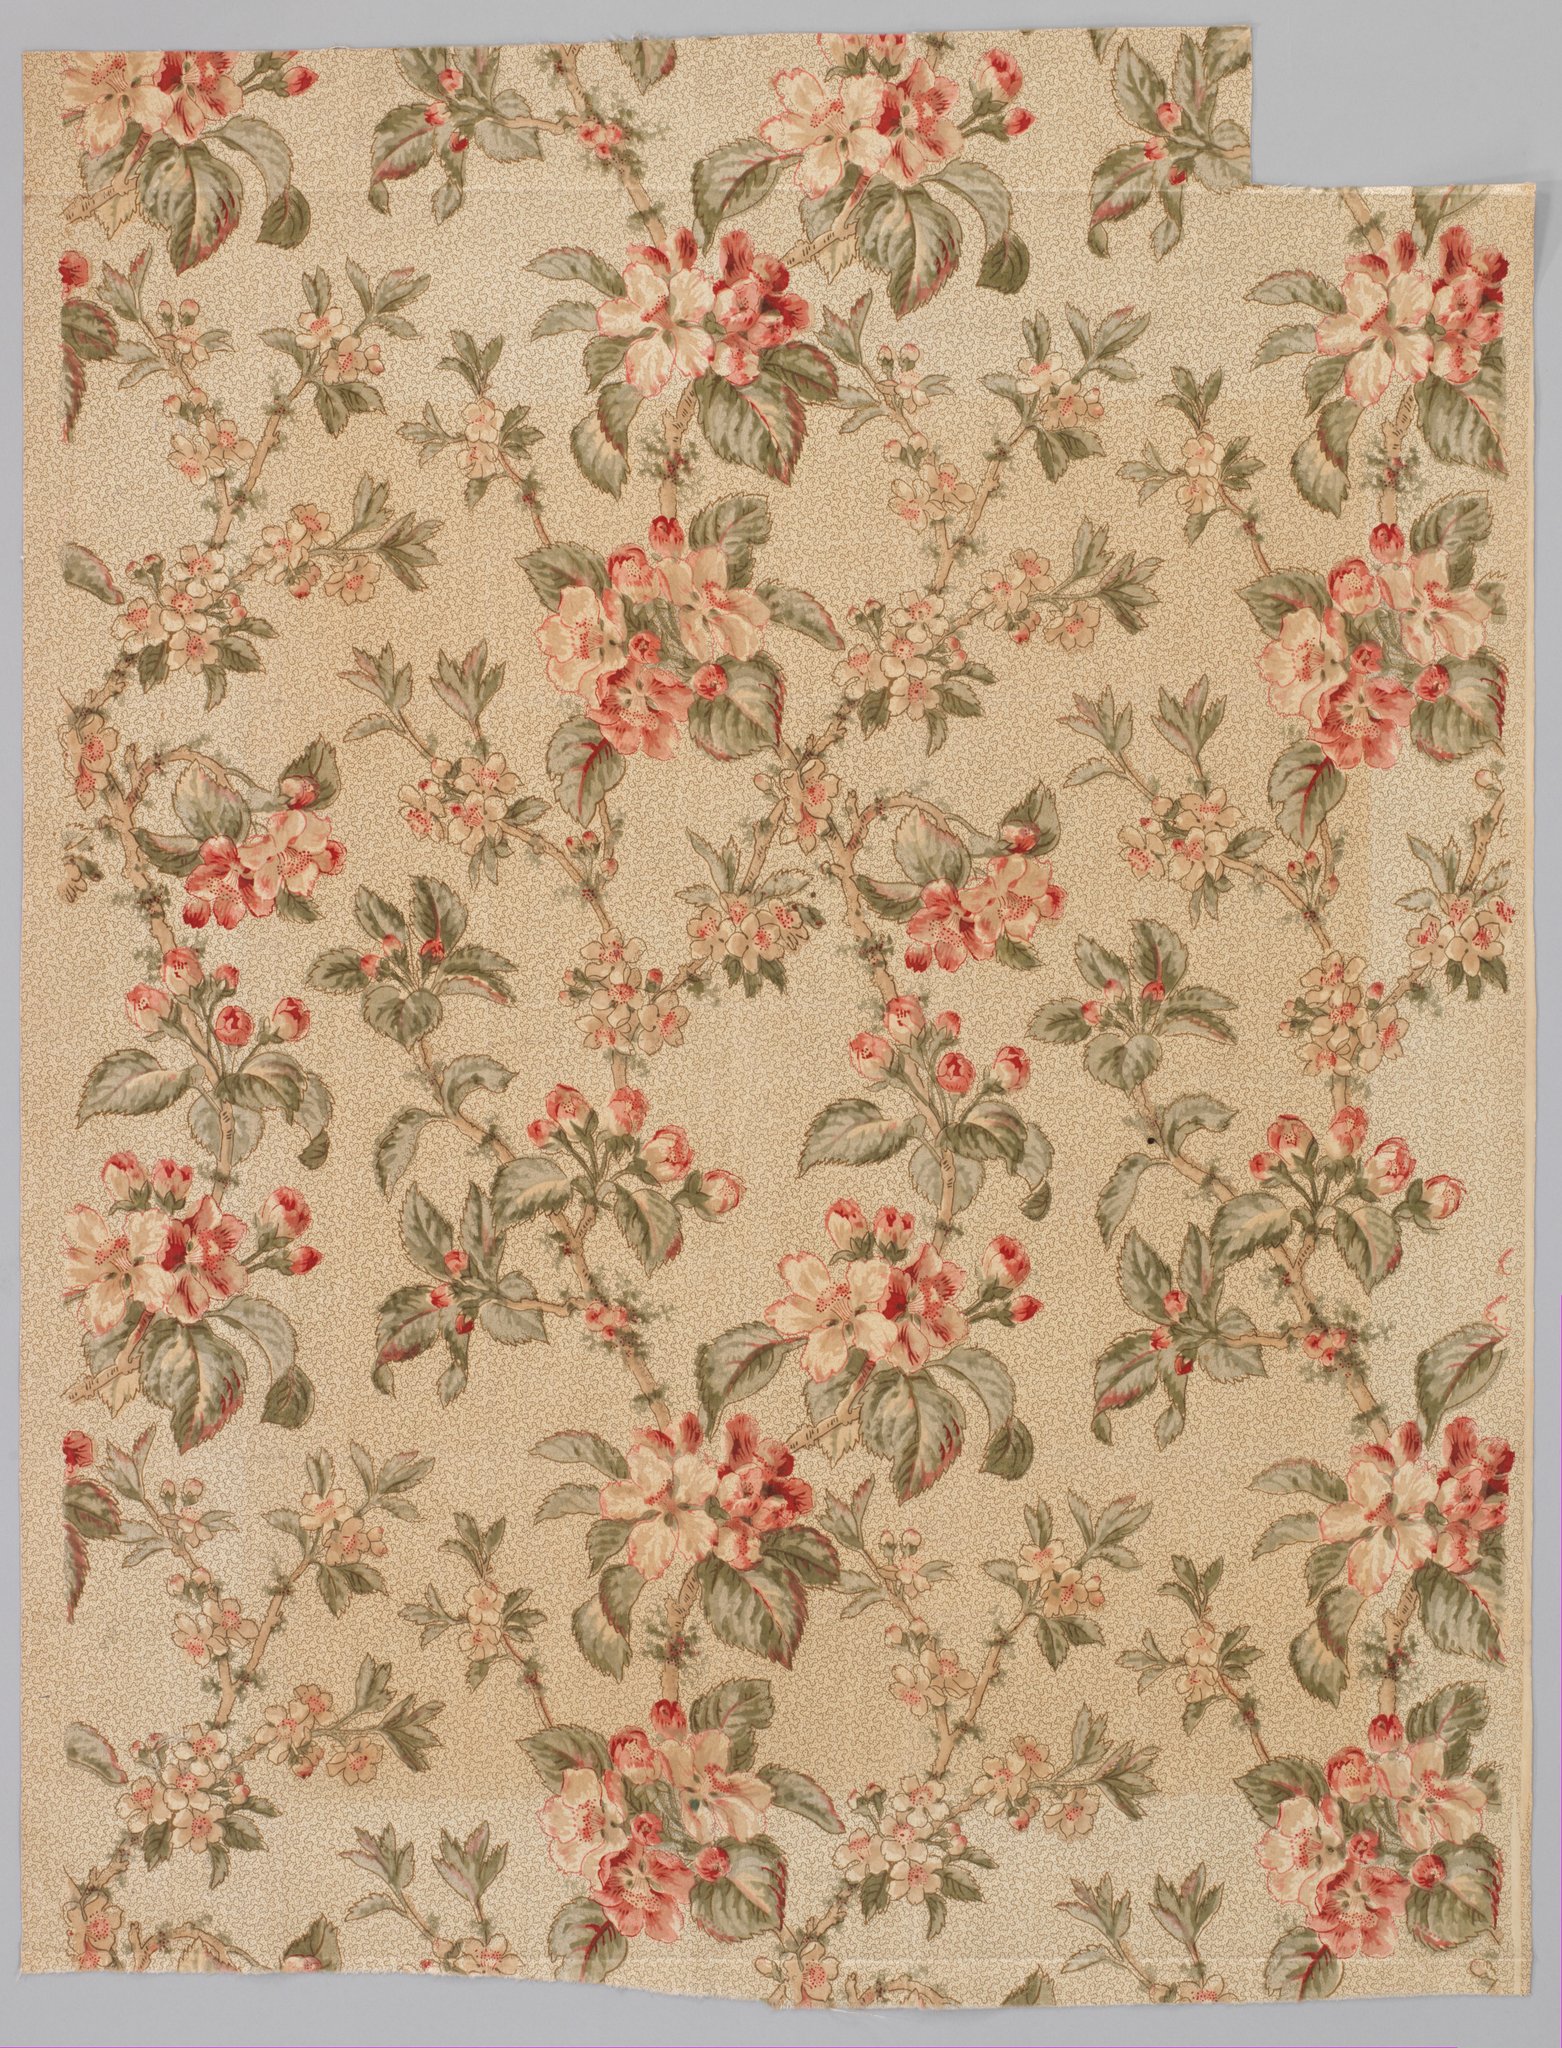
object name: piece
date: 1878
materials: cotton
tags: flowers